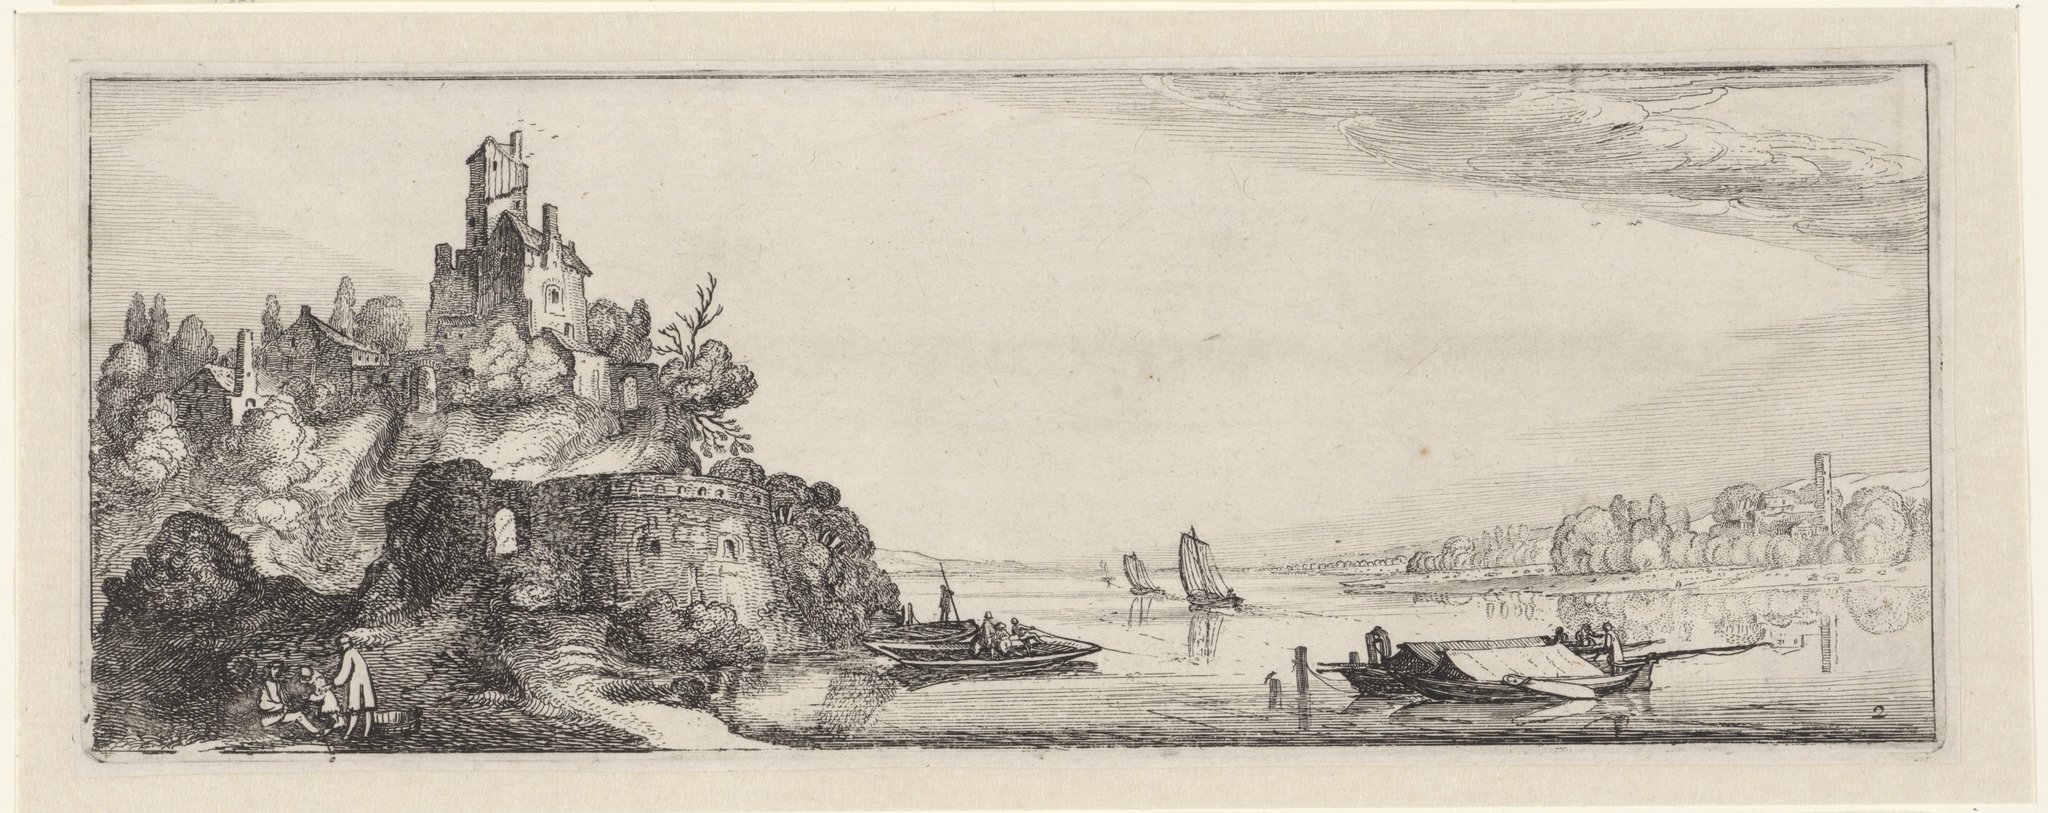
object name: print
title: Amoenissimae aliquot Regiunculae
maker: jan van de velde (ii)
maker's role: draughtsman, painter, print maker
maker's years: 1593-1641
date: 1615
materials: paper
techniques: etching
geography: northern netherlands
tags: landscape with tower or castle, landscapes with waters, waterscapes, seascapes (in the temperate zone) (+ landscape with figures, staffage)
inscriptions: collector's mark: Lugt 240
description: Rivierlandschap met een versterkt huis op een rots. Tweede prent uit een serie van achttien.